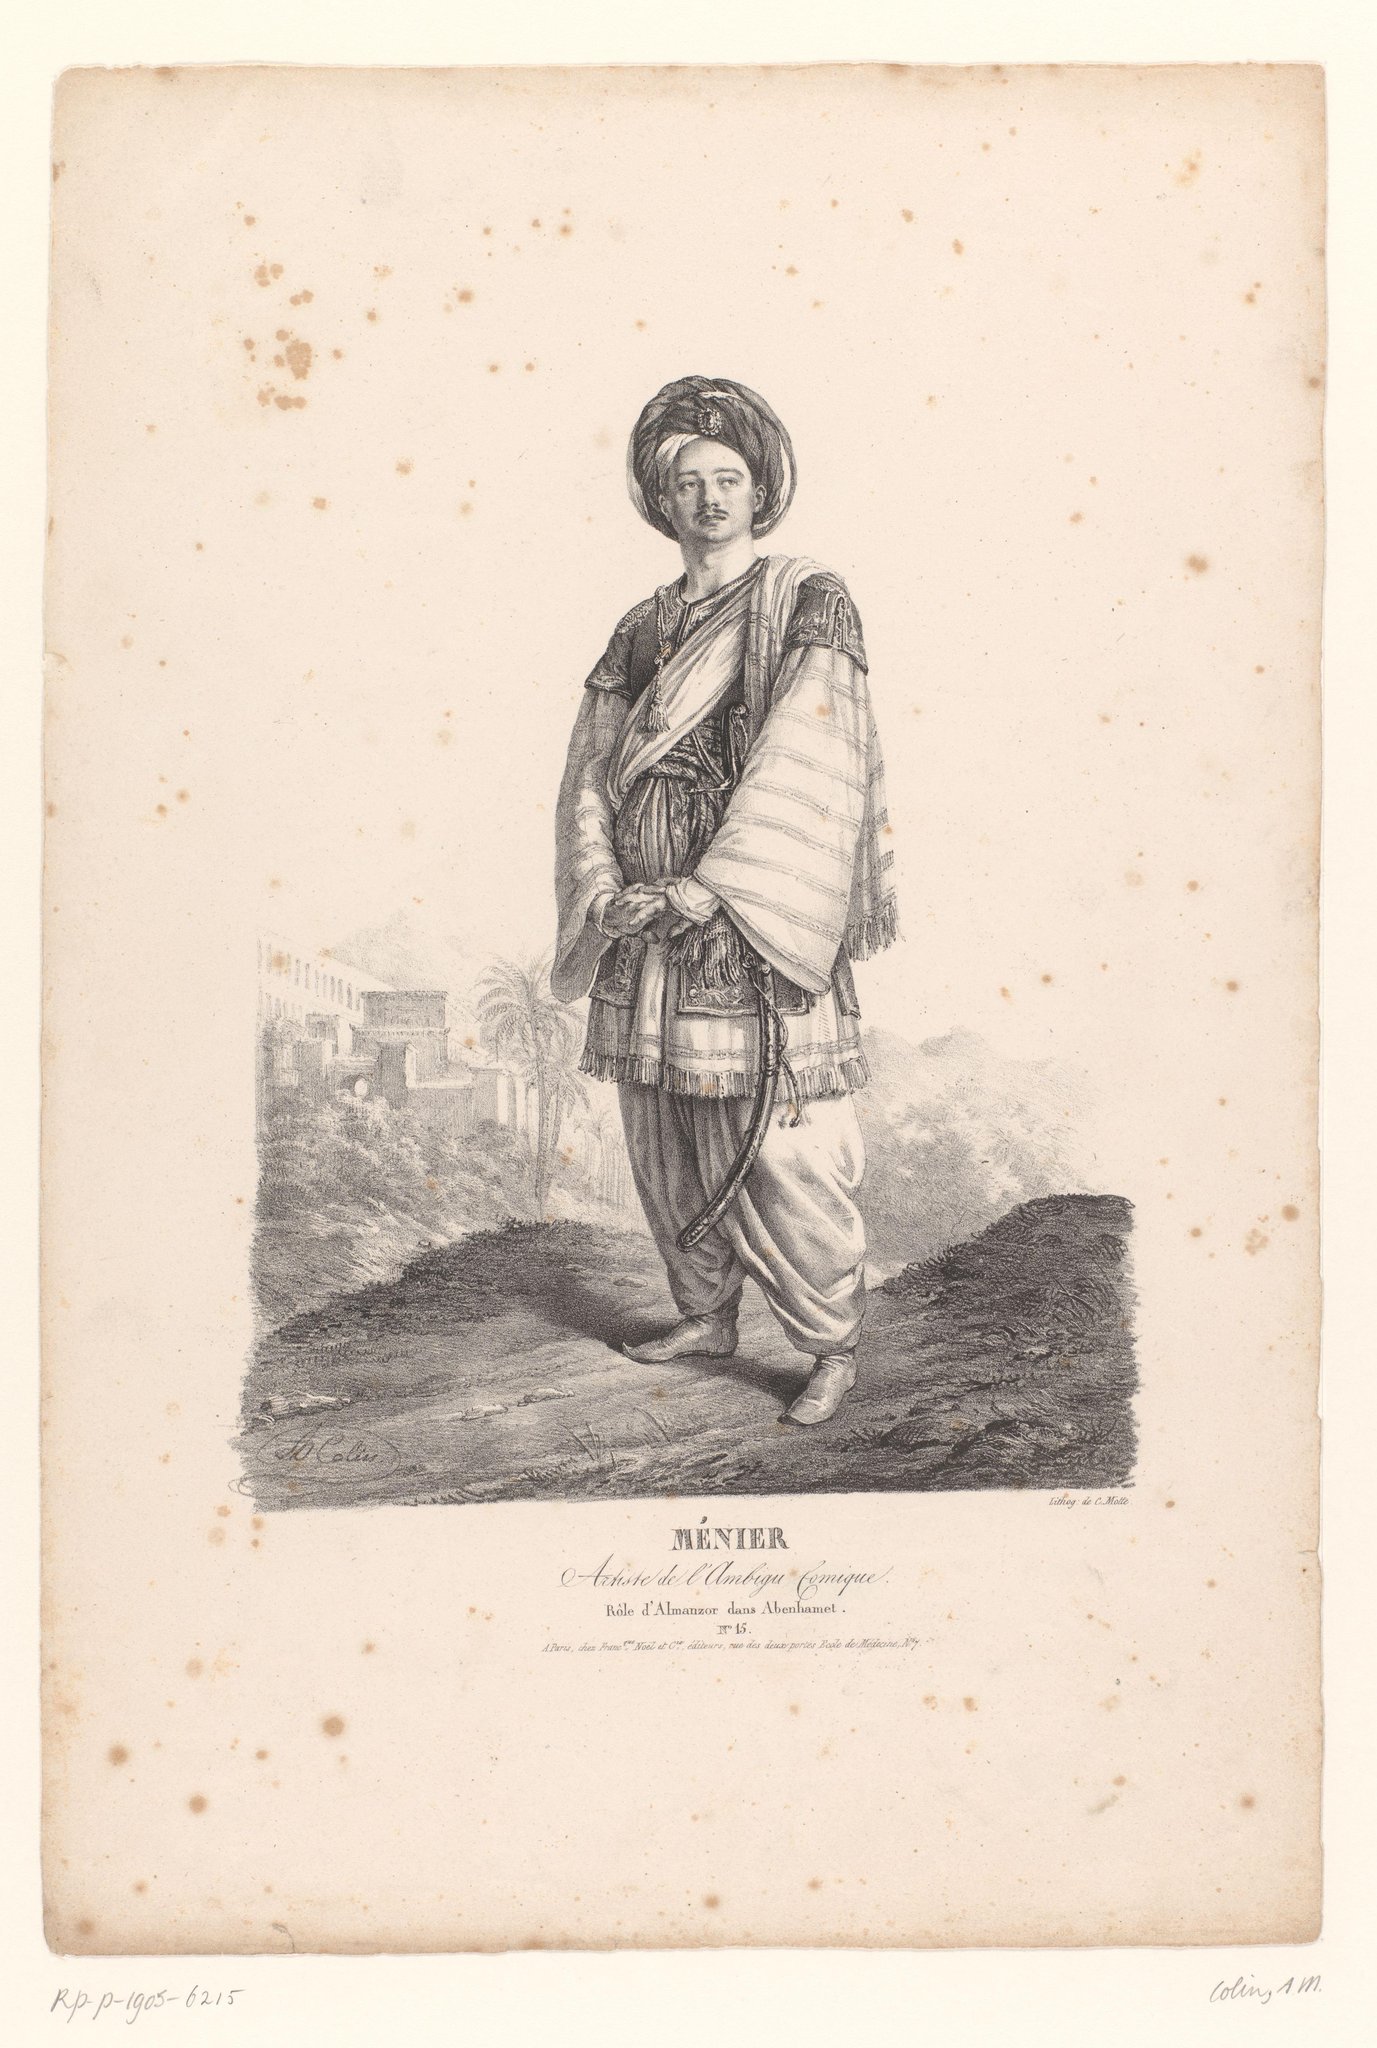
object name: print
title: Portret van Paulin Ménier als Almanzor in het melodrama Abenhamet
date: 1823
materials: paper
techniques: lithograph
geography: paris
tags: stage costume, portrait of actor, actress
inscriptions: collector's mark: Lugt 2228a